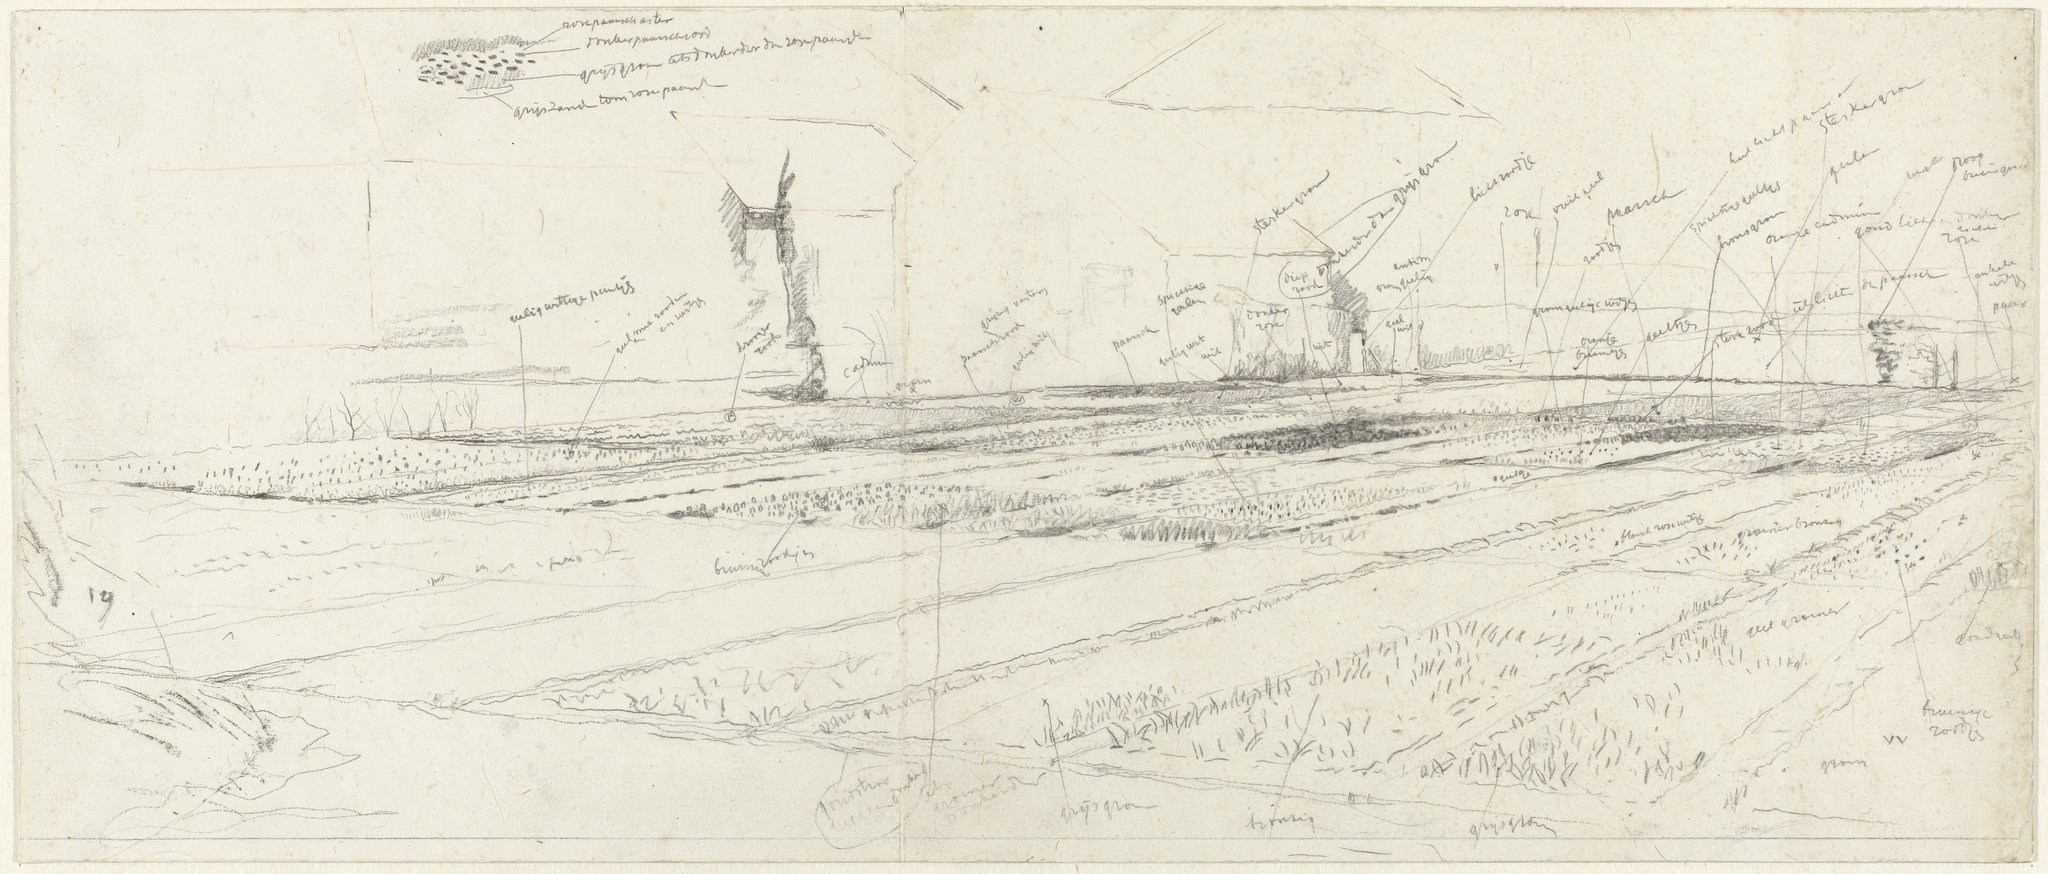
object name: drawing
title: Tuintjes of velden tussen huizen, met kleurnotities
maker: gerrit willem dijsselhof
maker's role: designer, draughtsman, print maker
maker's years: 1866-1924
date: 1876-1924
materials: chalk, paper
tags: garden